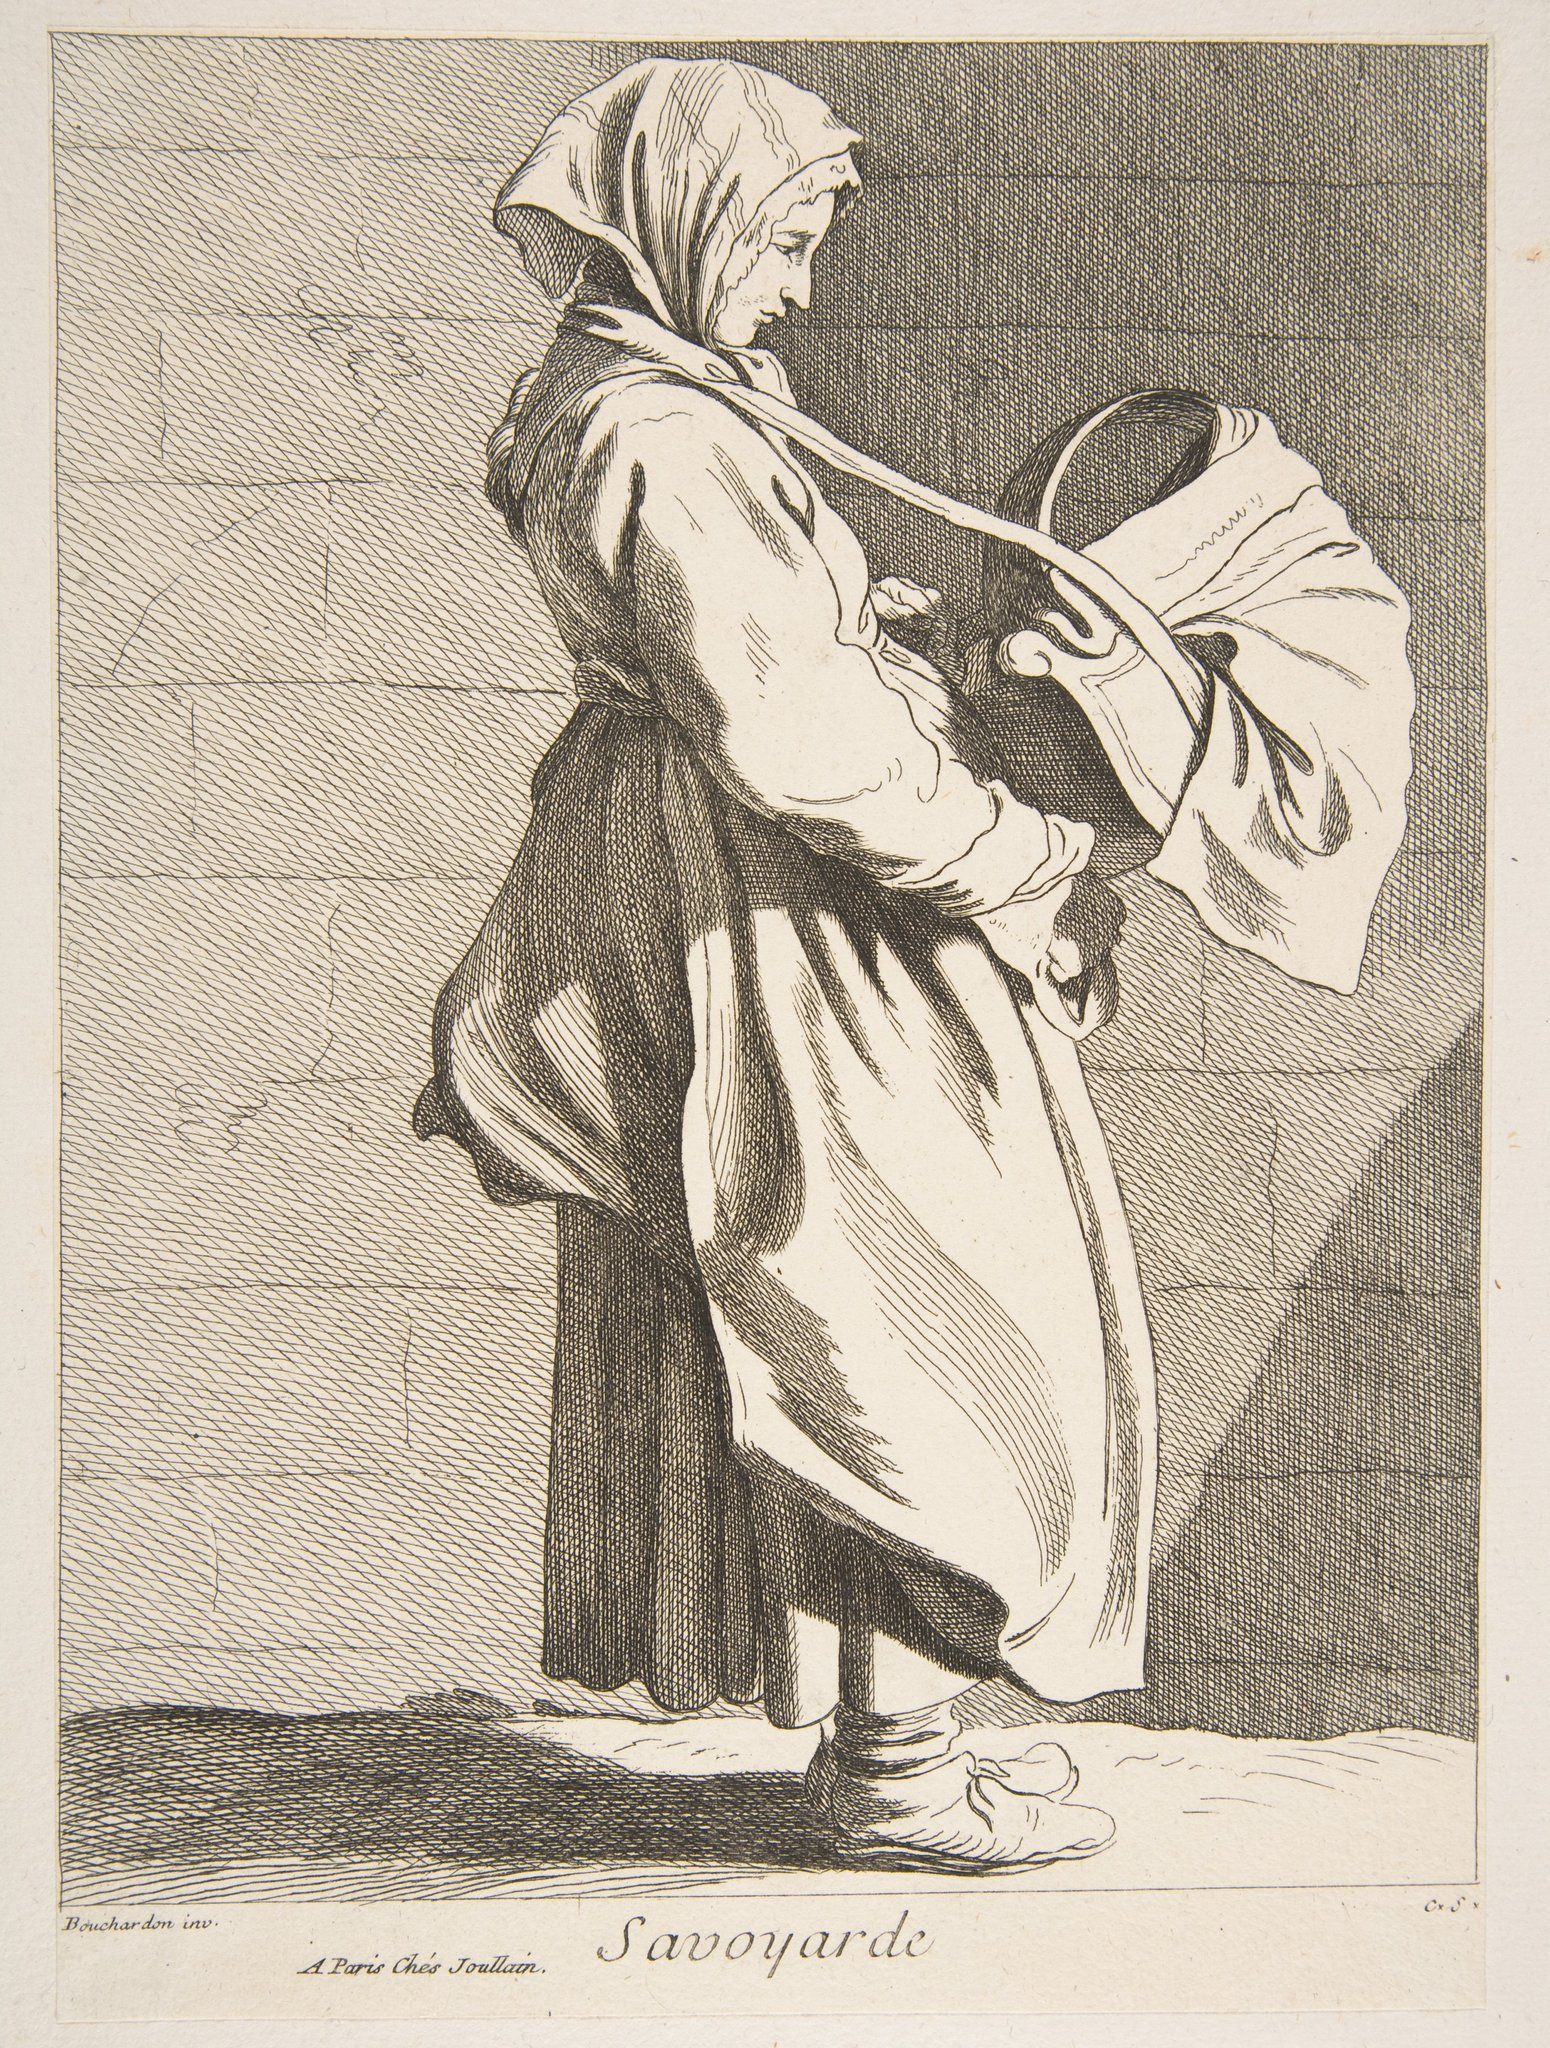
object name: print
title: A Woman from Savoy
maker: anne claude philippe de tubières, comte de caylus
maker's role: artist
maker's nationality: french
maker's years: 1692-1765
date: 1742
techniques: engraving, etching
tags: women